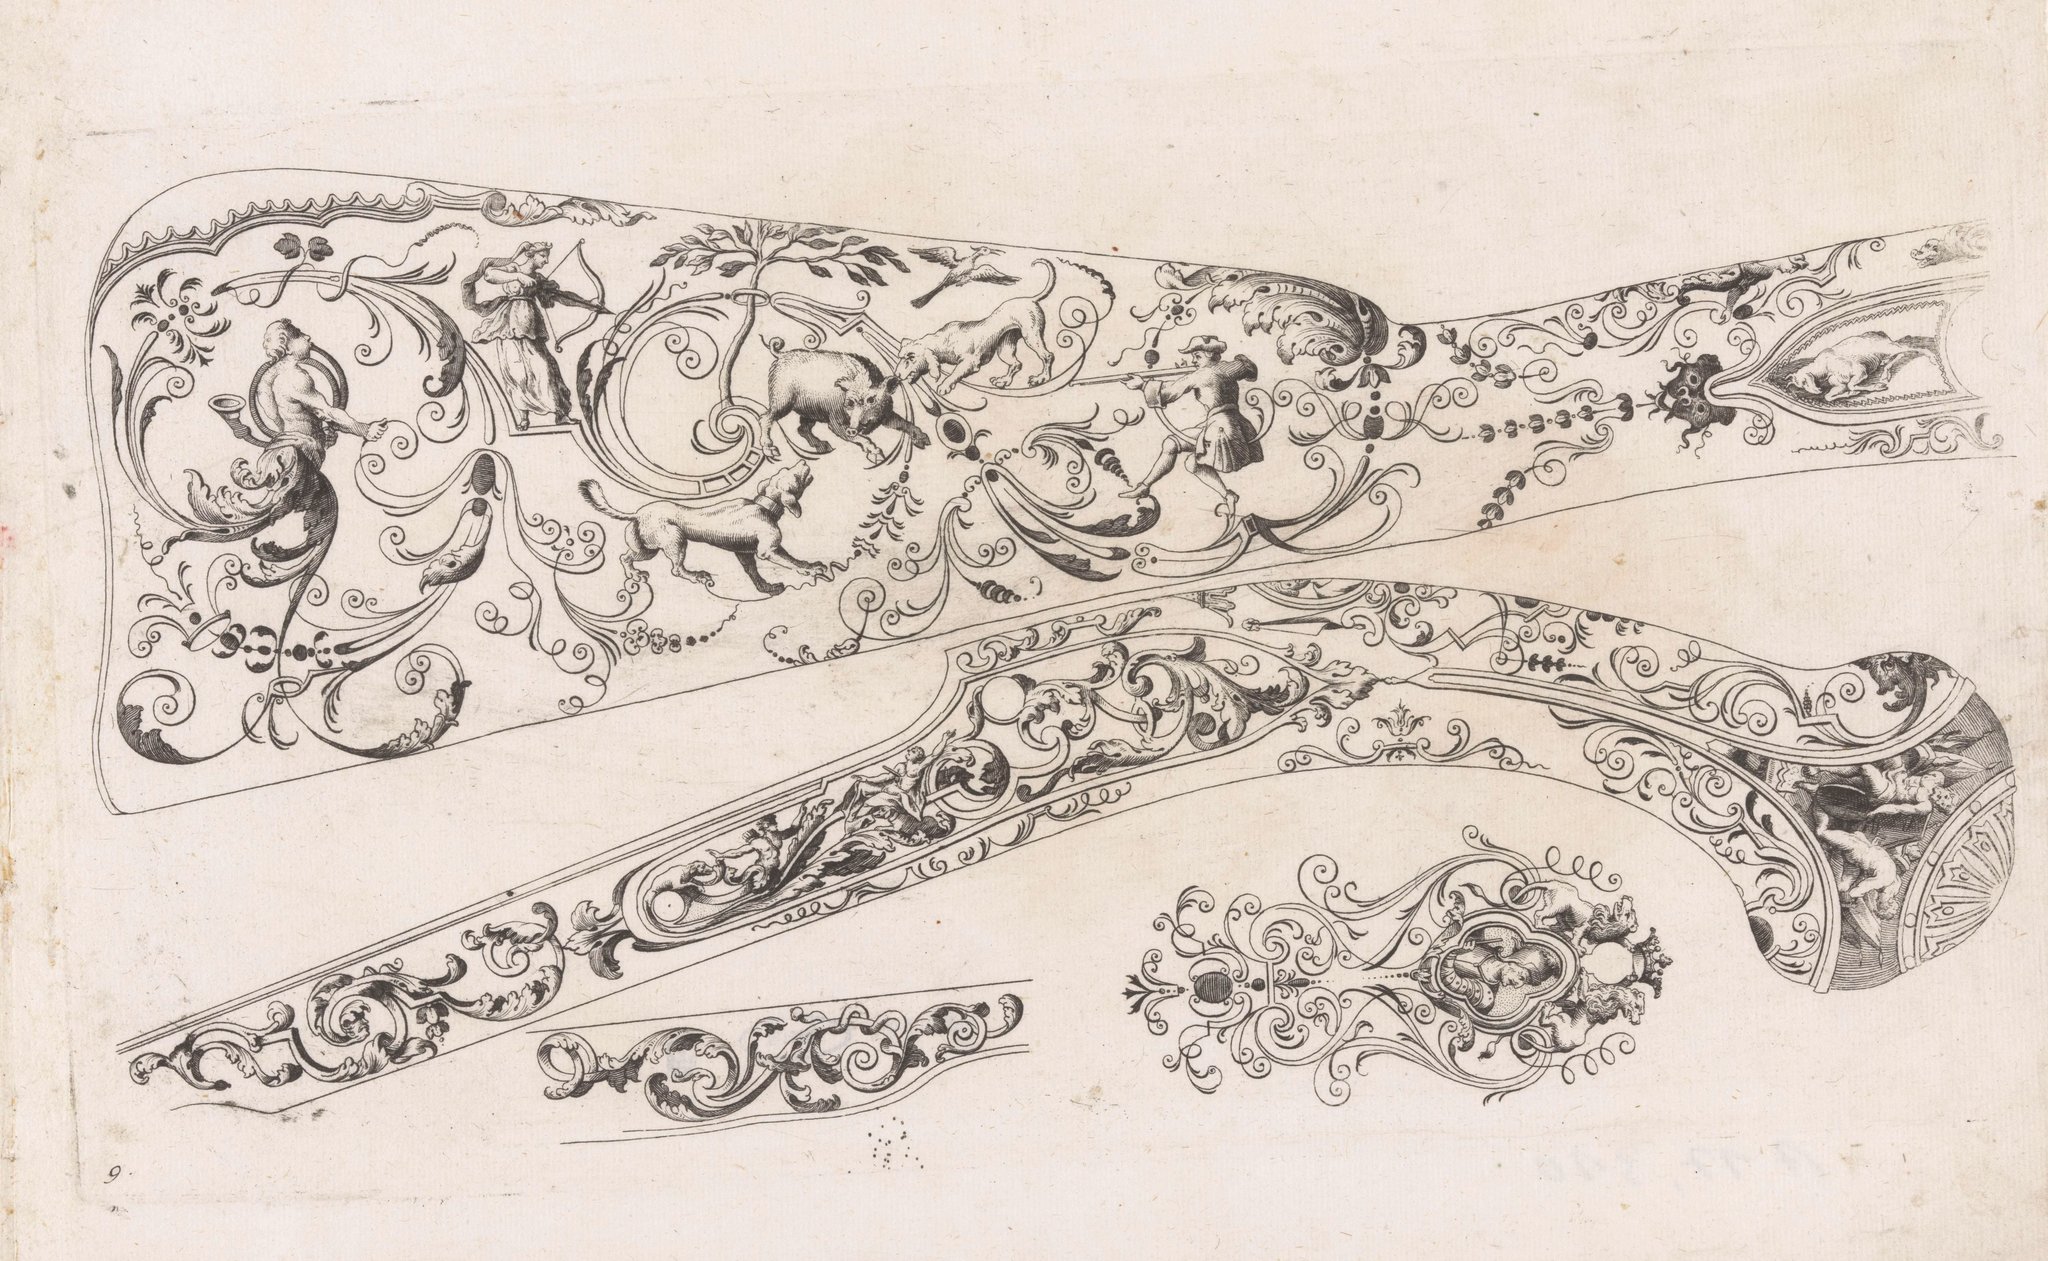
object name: ornament print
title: Kolf en kolfkap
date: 1690-1725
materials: paper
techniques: etching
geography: nuremberg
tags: weapons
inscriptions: collector's mark: Lugt 2228, collector's mark: Lugt 2760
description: Duitse editie van de serie Diverses Pieces D'Arquebuserie (...) van Nicolas Guerard.